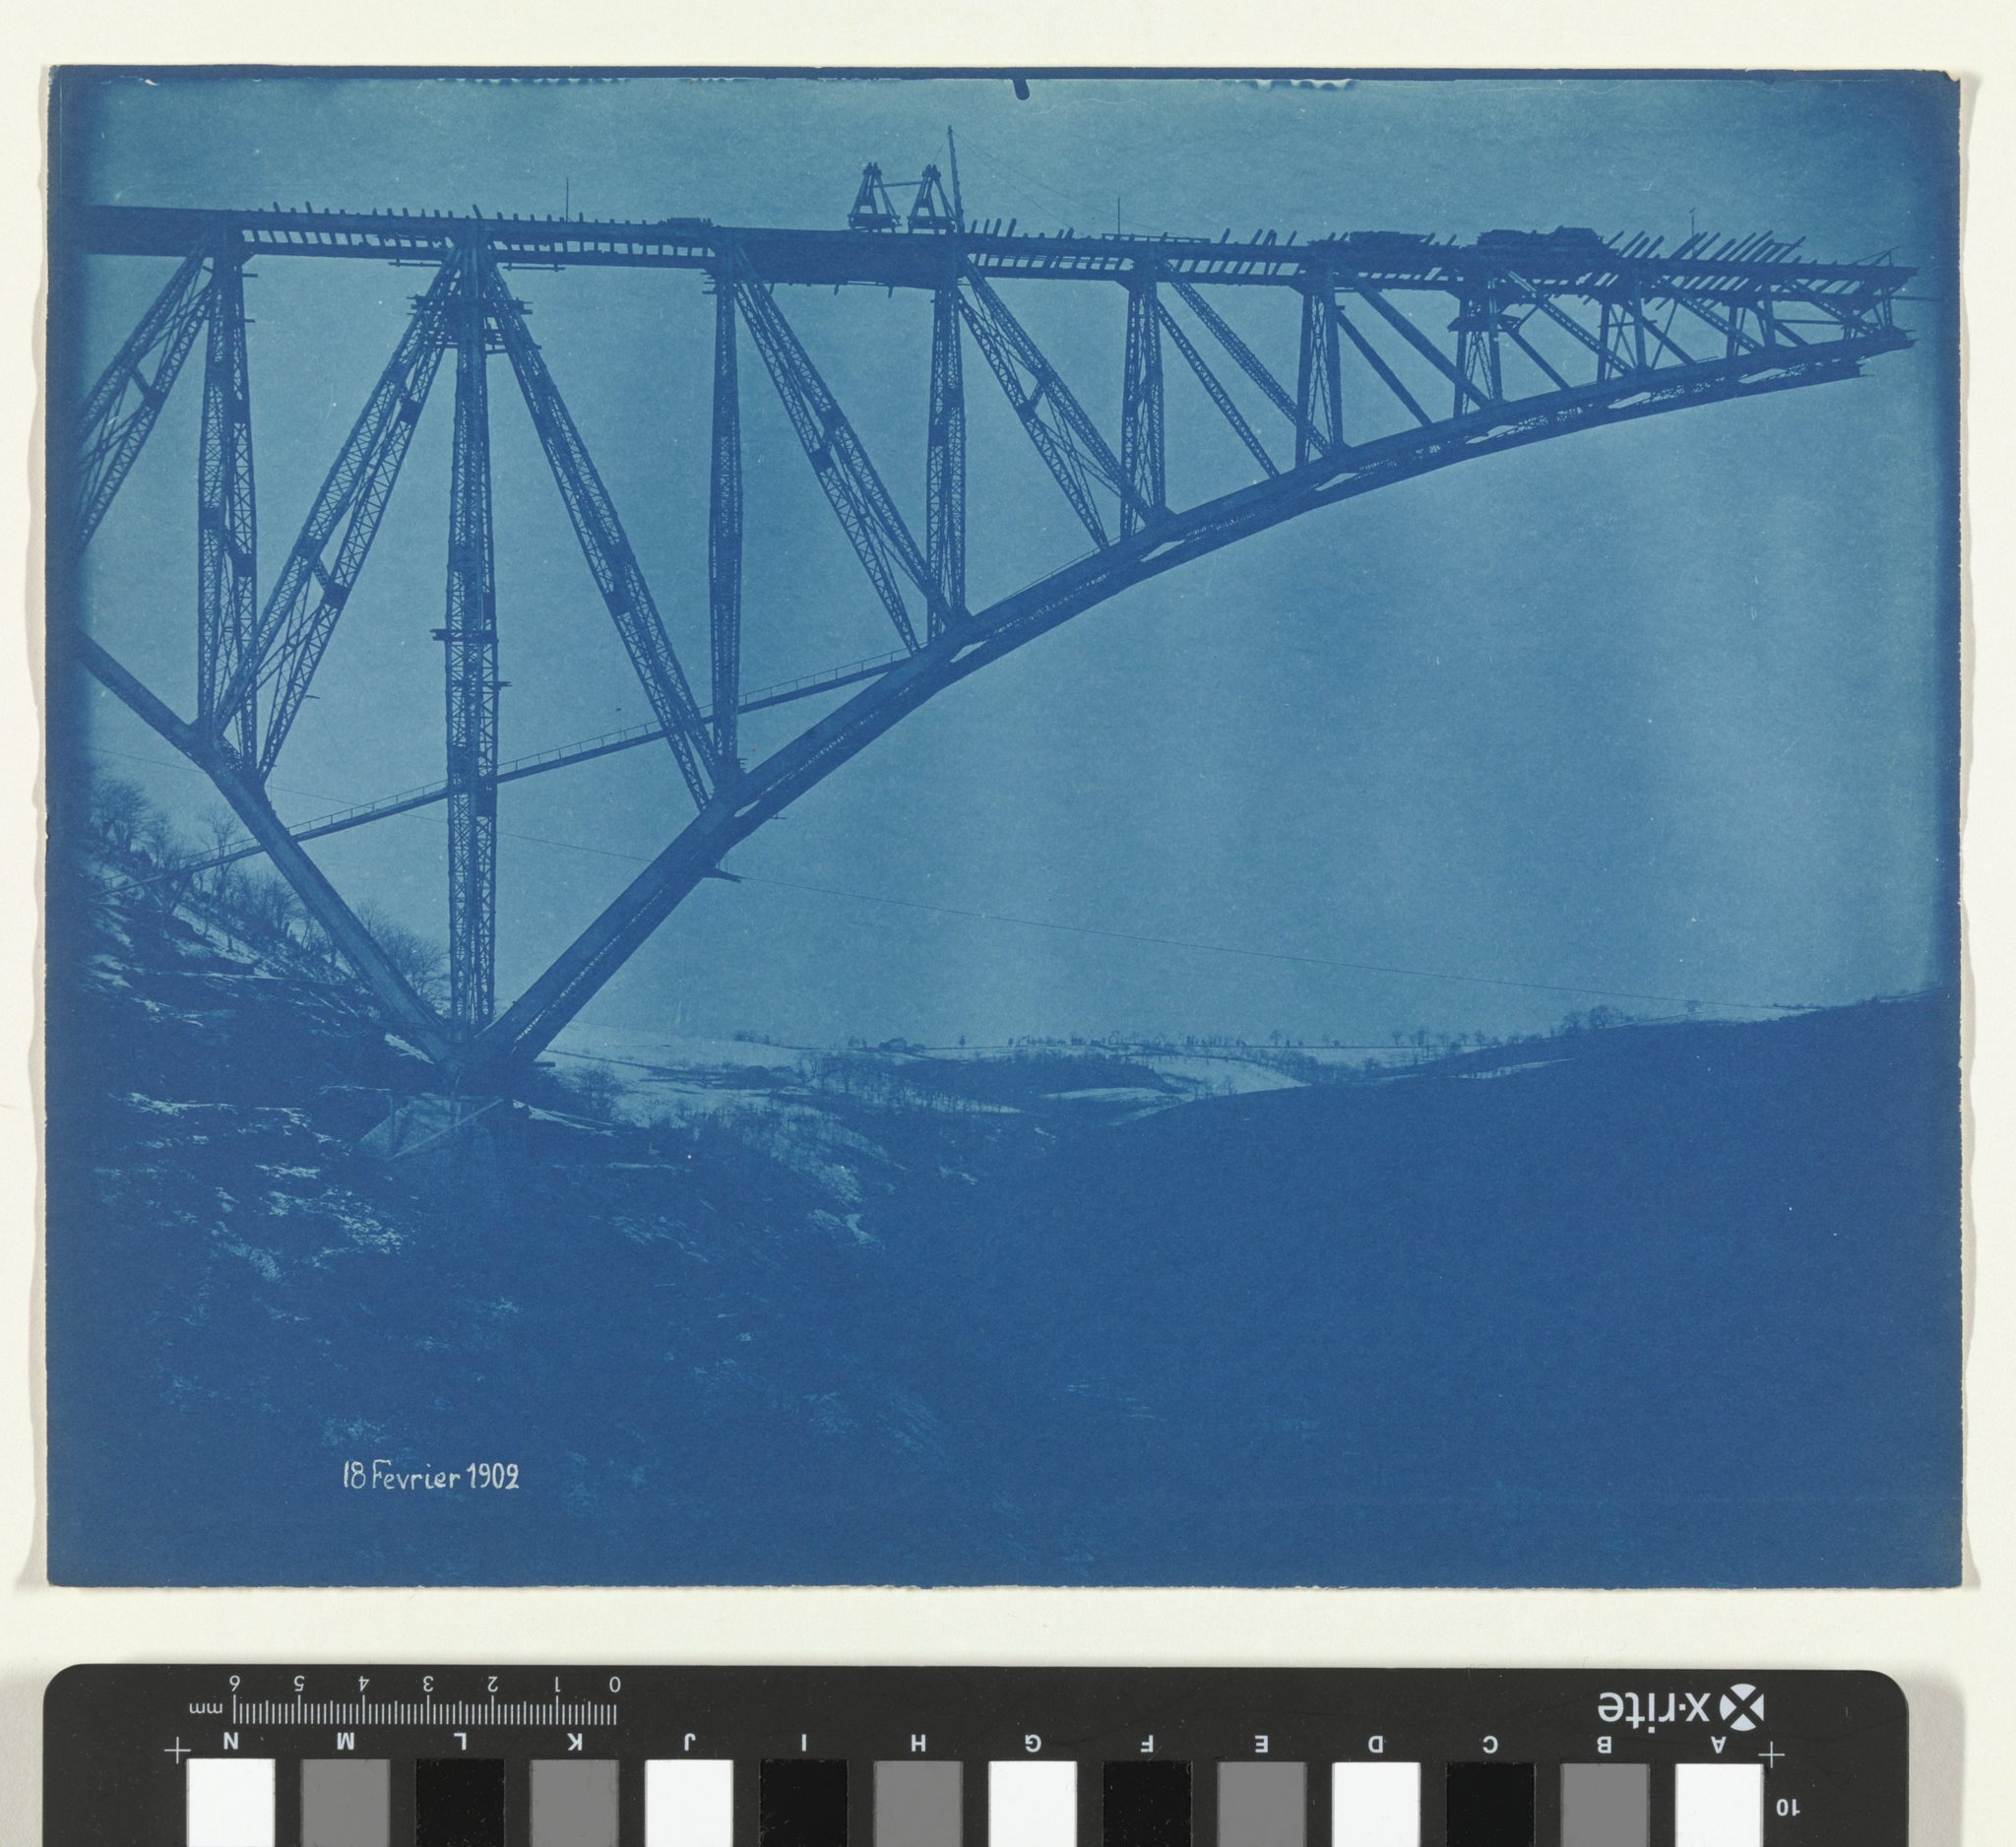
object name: photograph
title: Aanleg van het Viaur Viaduct in Frankrijk door de Societé de Construction des Battignolles, 18 februari 1902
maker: Anonymous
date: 1902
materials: photographic support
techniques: cyanotype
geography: france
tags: viaduct, making the overground structures (~ building activities)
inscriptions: date